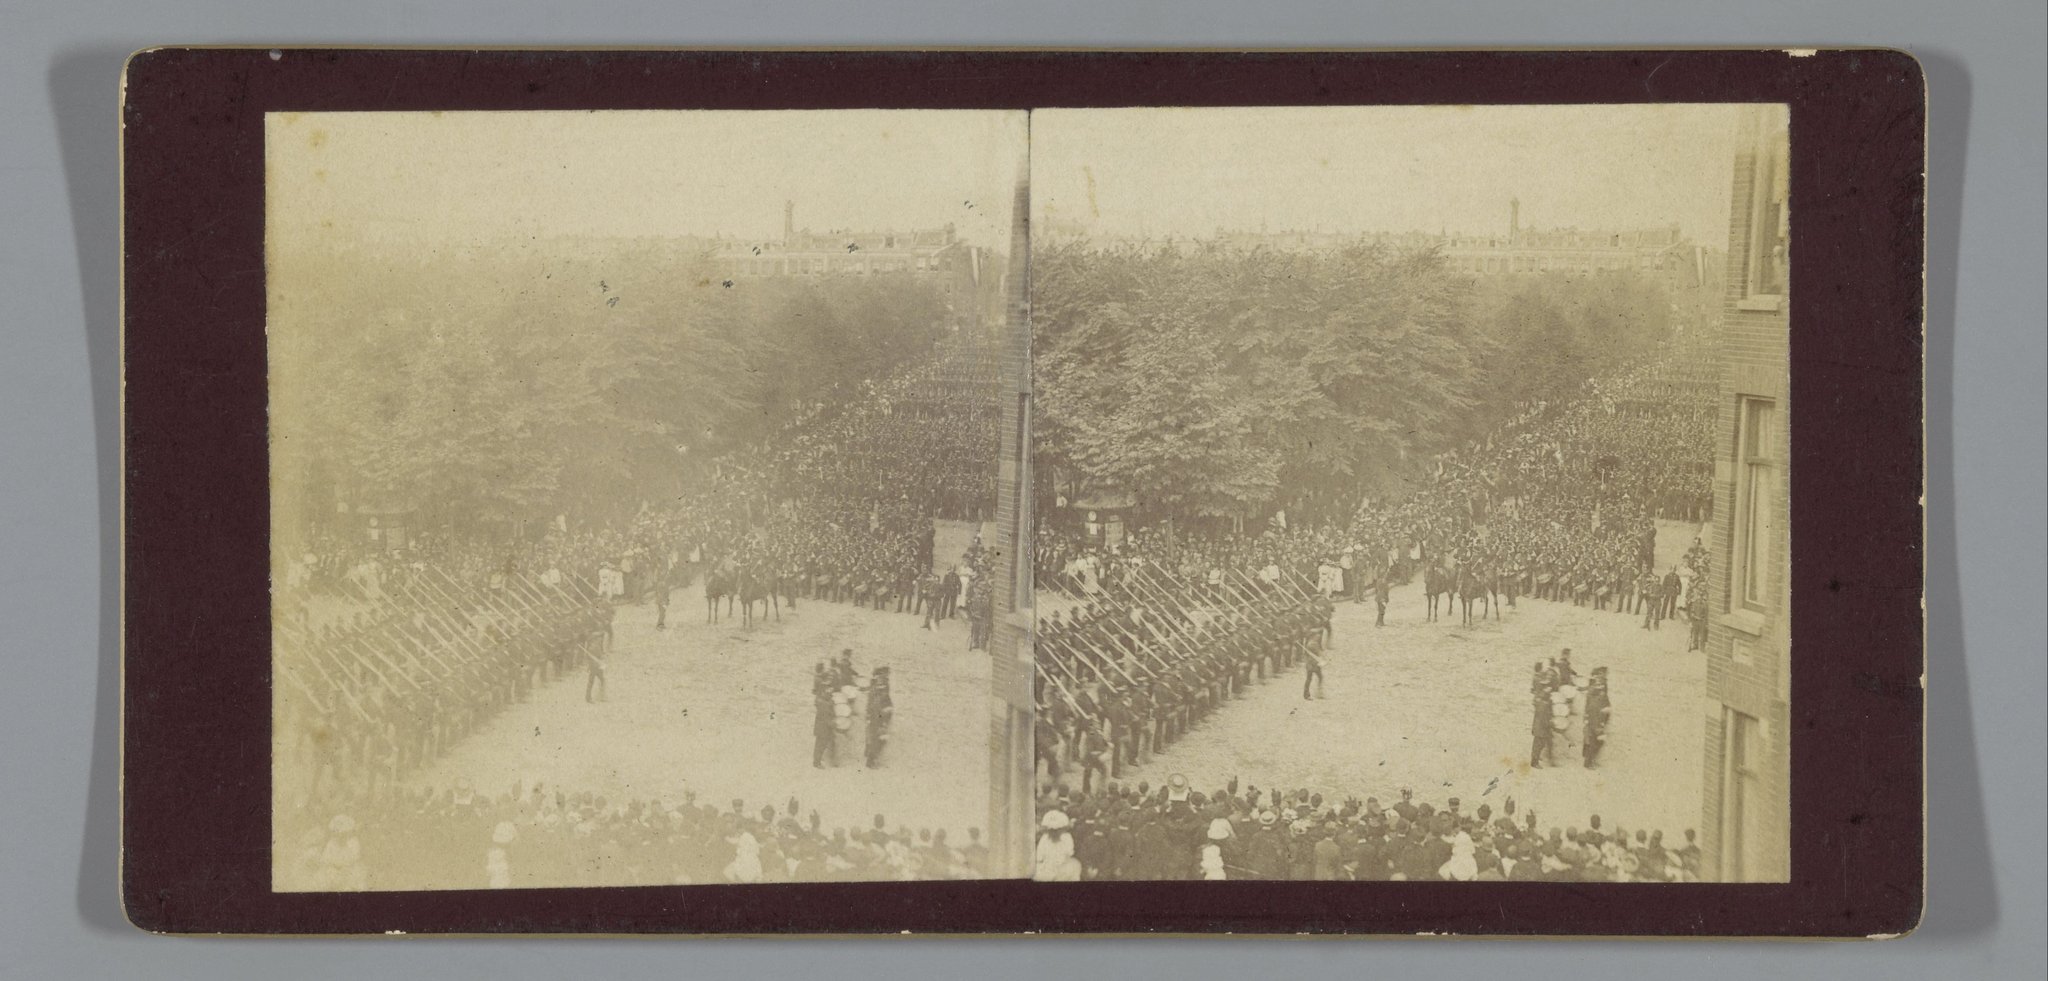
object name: stereograph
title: Optocht met militair optreden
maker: Anonymous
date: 1868-1890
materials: cardboard, paper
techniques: albumen print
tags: military parade, pageant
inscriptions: number: ‘67.’